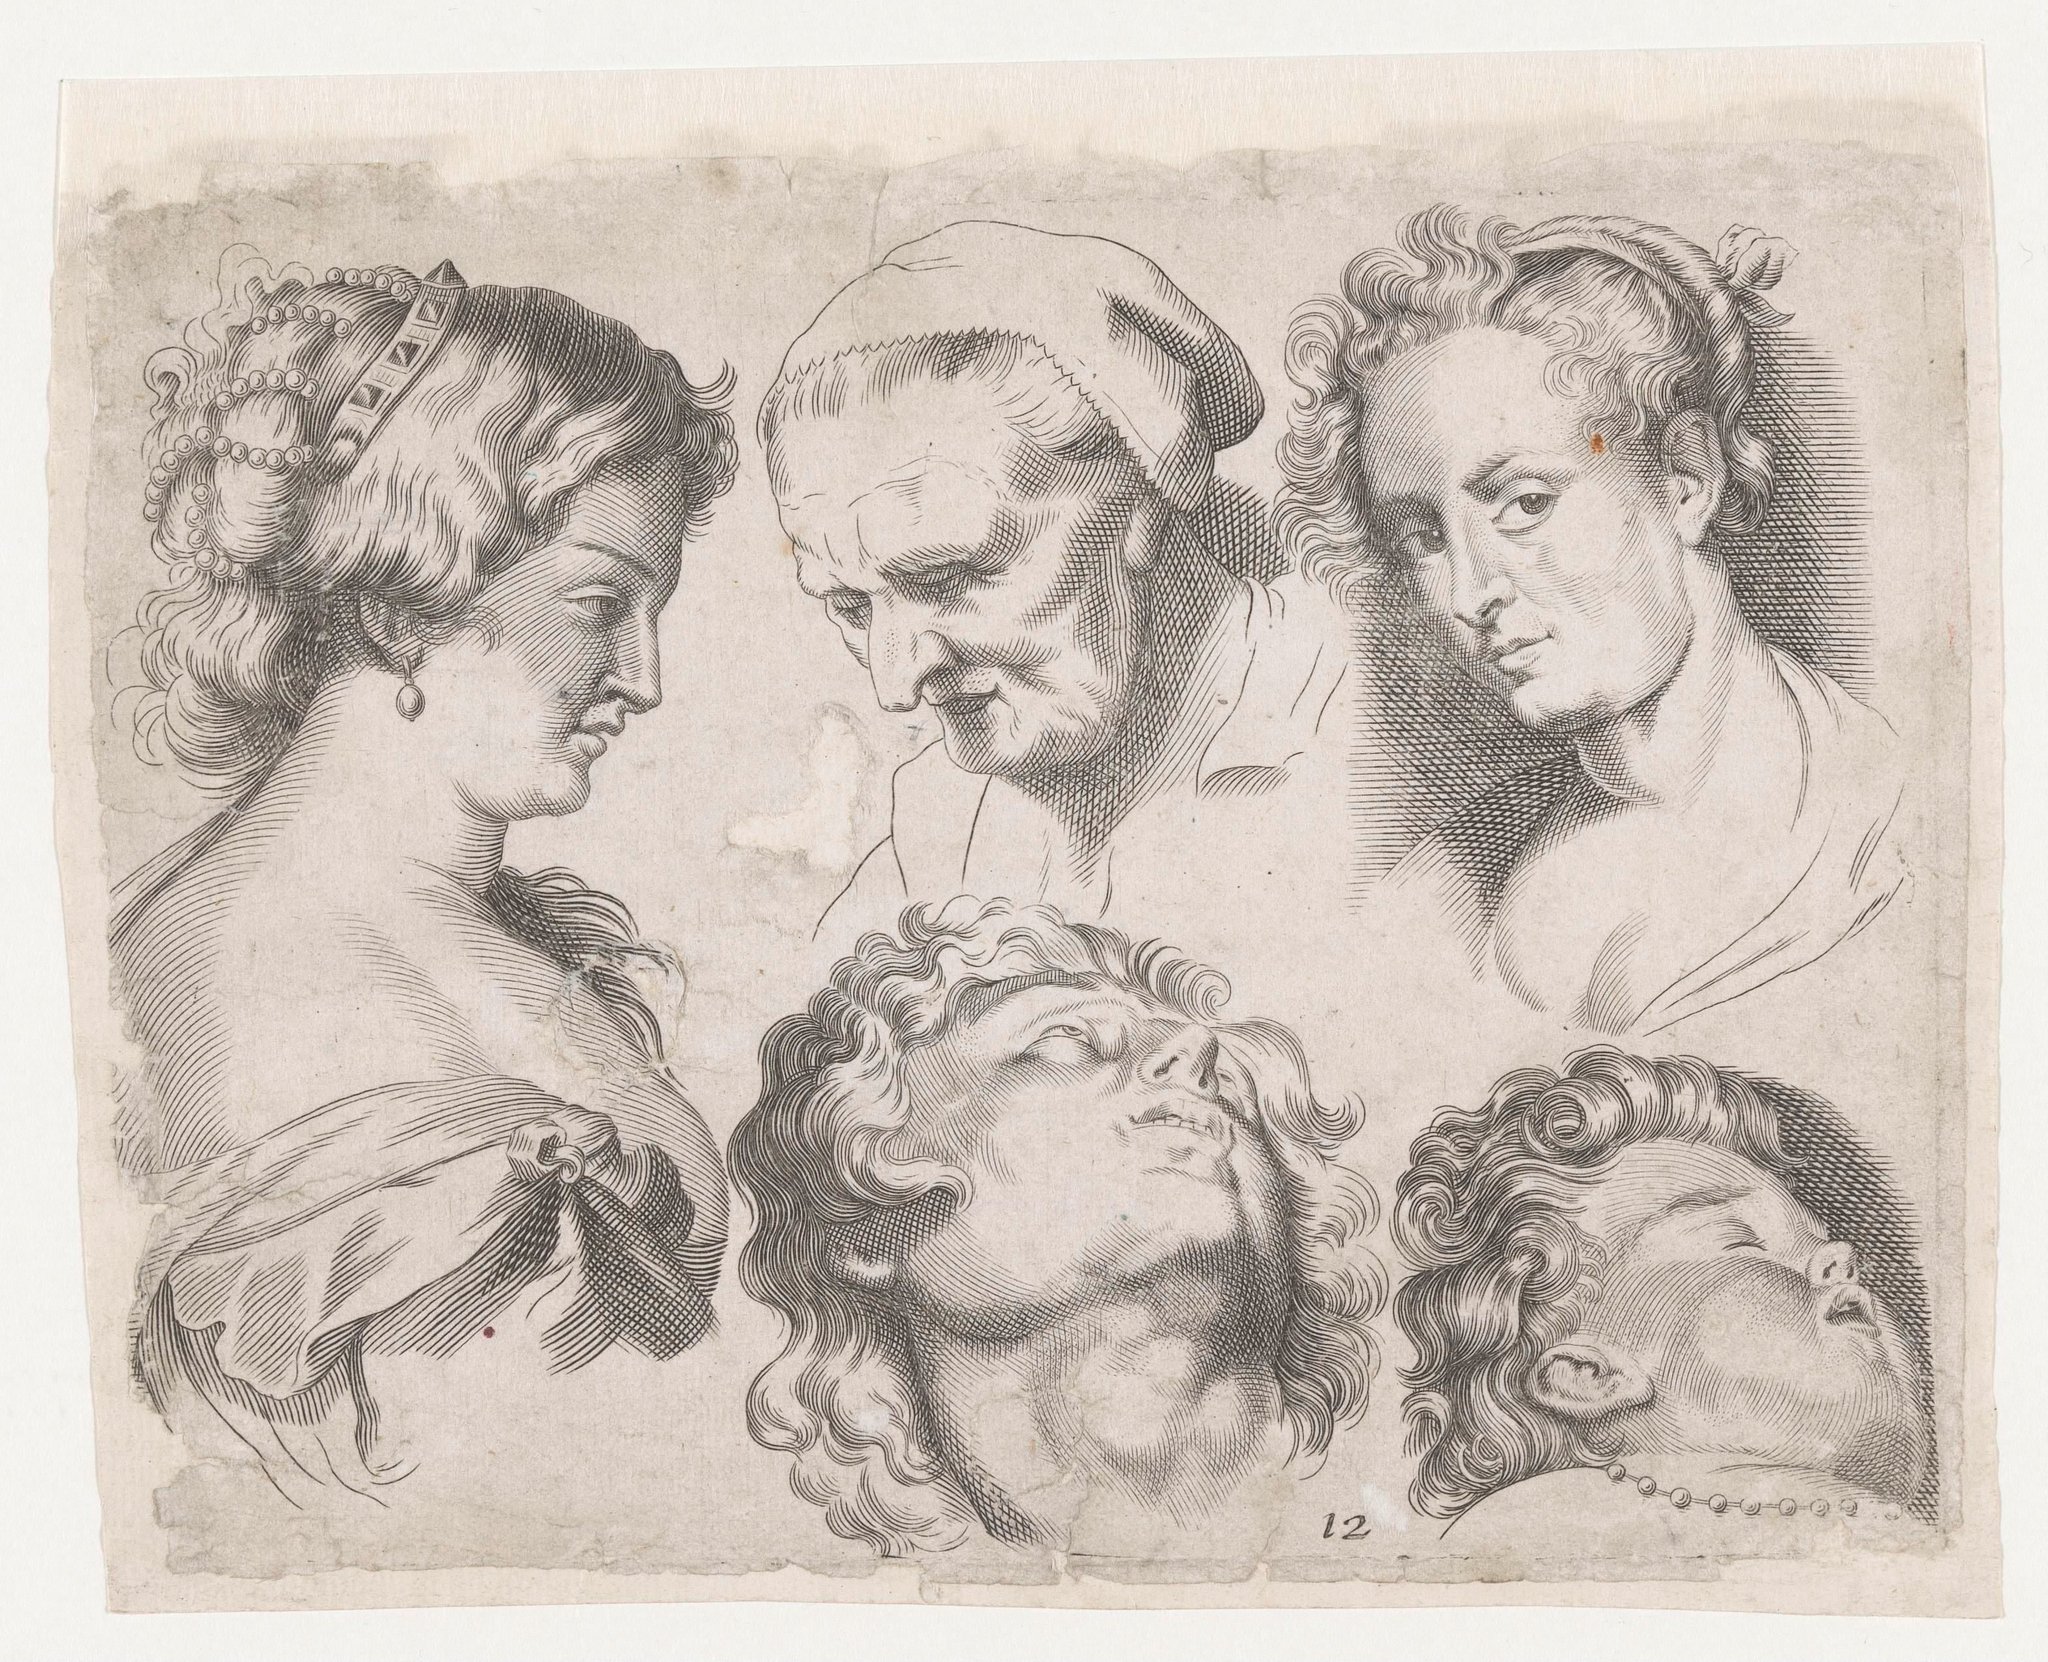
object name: print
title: Studies van vrouwen, man en baby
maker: Anonymous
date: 1650-1750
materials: paper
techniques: engraving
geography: netherlands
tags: drawing, sketch, head (human)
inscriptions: : ‘m.o.: 12’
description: Studies van hoofden van jonge vrouwen, een oude vrouw, een jongeman en een baby. Midden onder 12 genummerd.